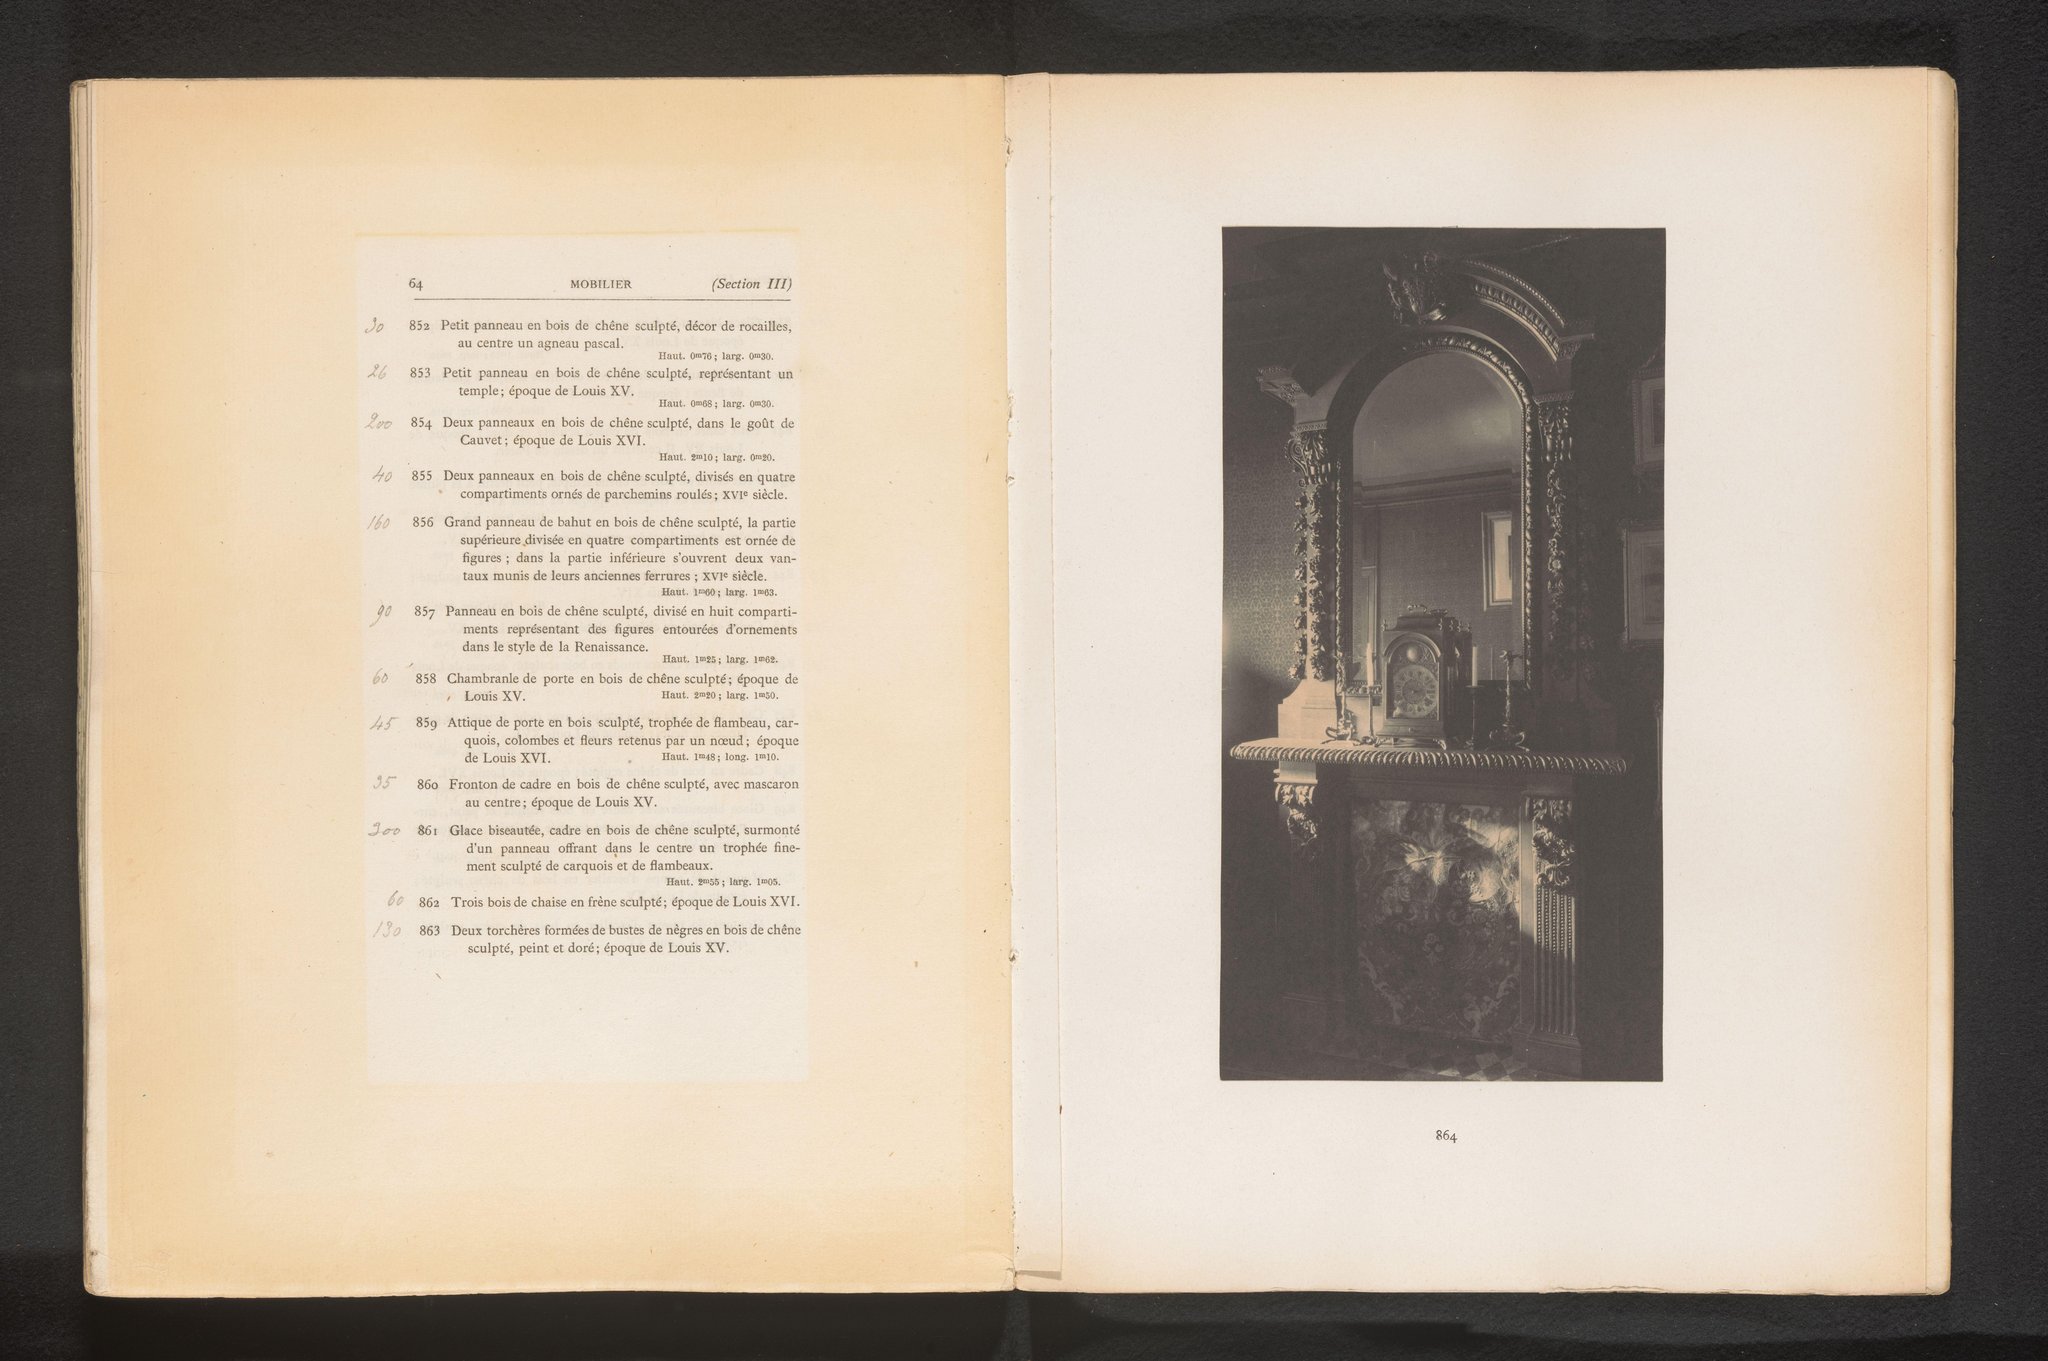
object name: photograph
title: Schoorsteen met klok in het huis van Antonin Terme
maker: Anonymous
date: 1880-1885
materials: photographic support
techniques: platinum process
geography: liège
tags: art collection, art gallery, clock, chimney-piece, mantelpiece